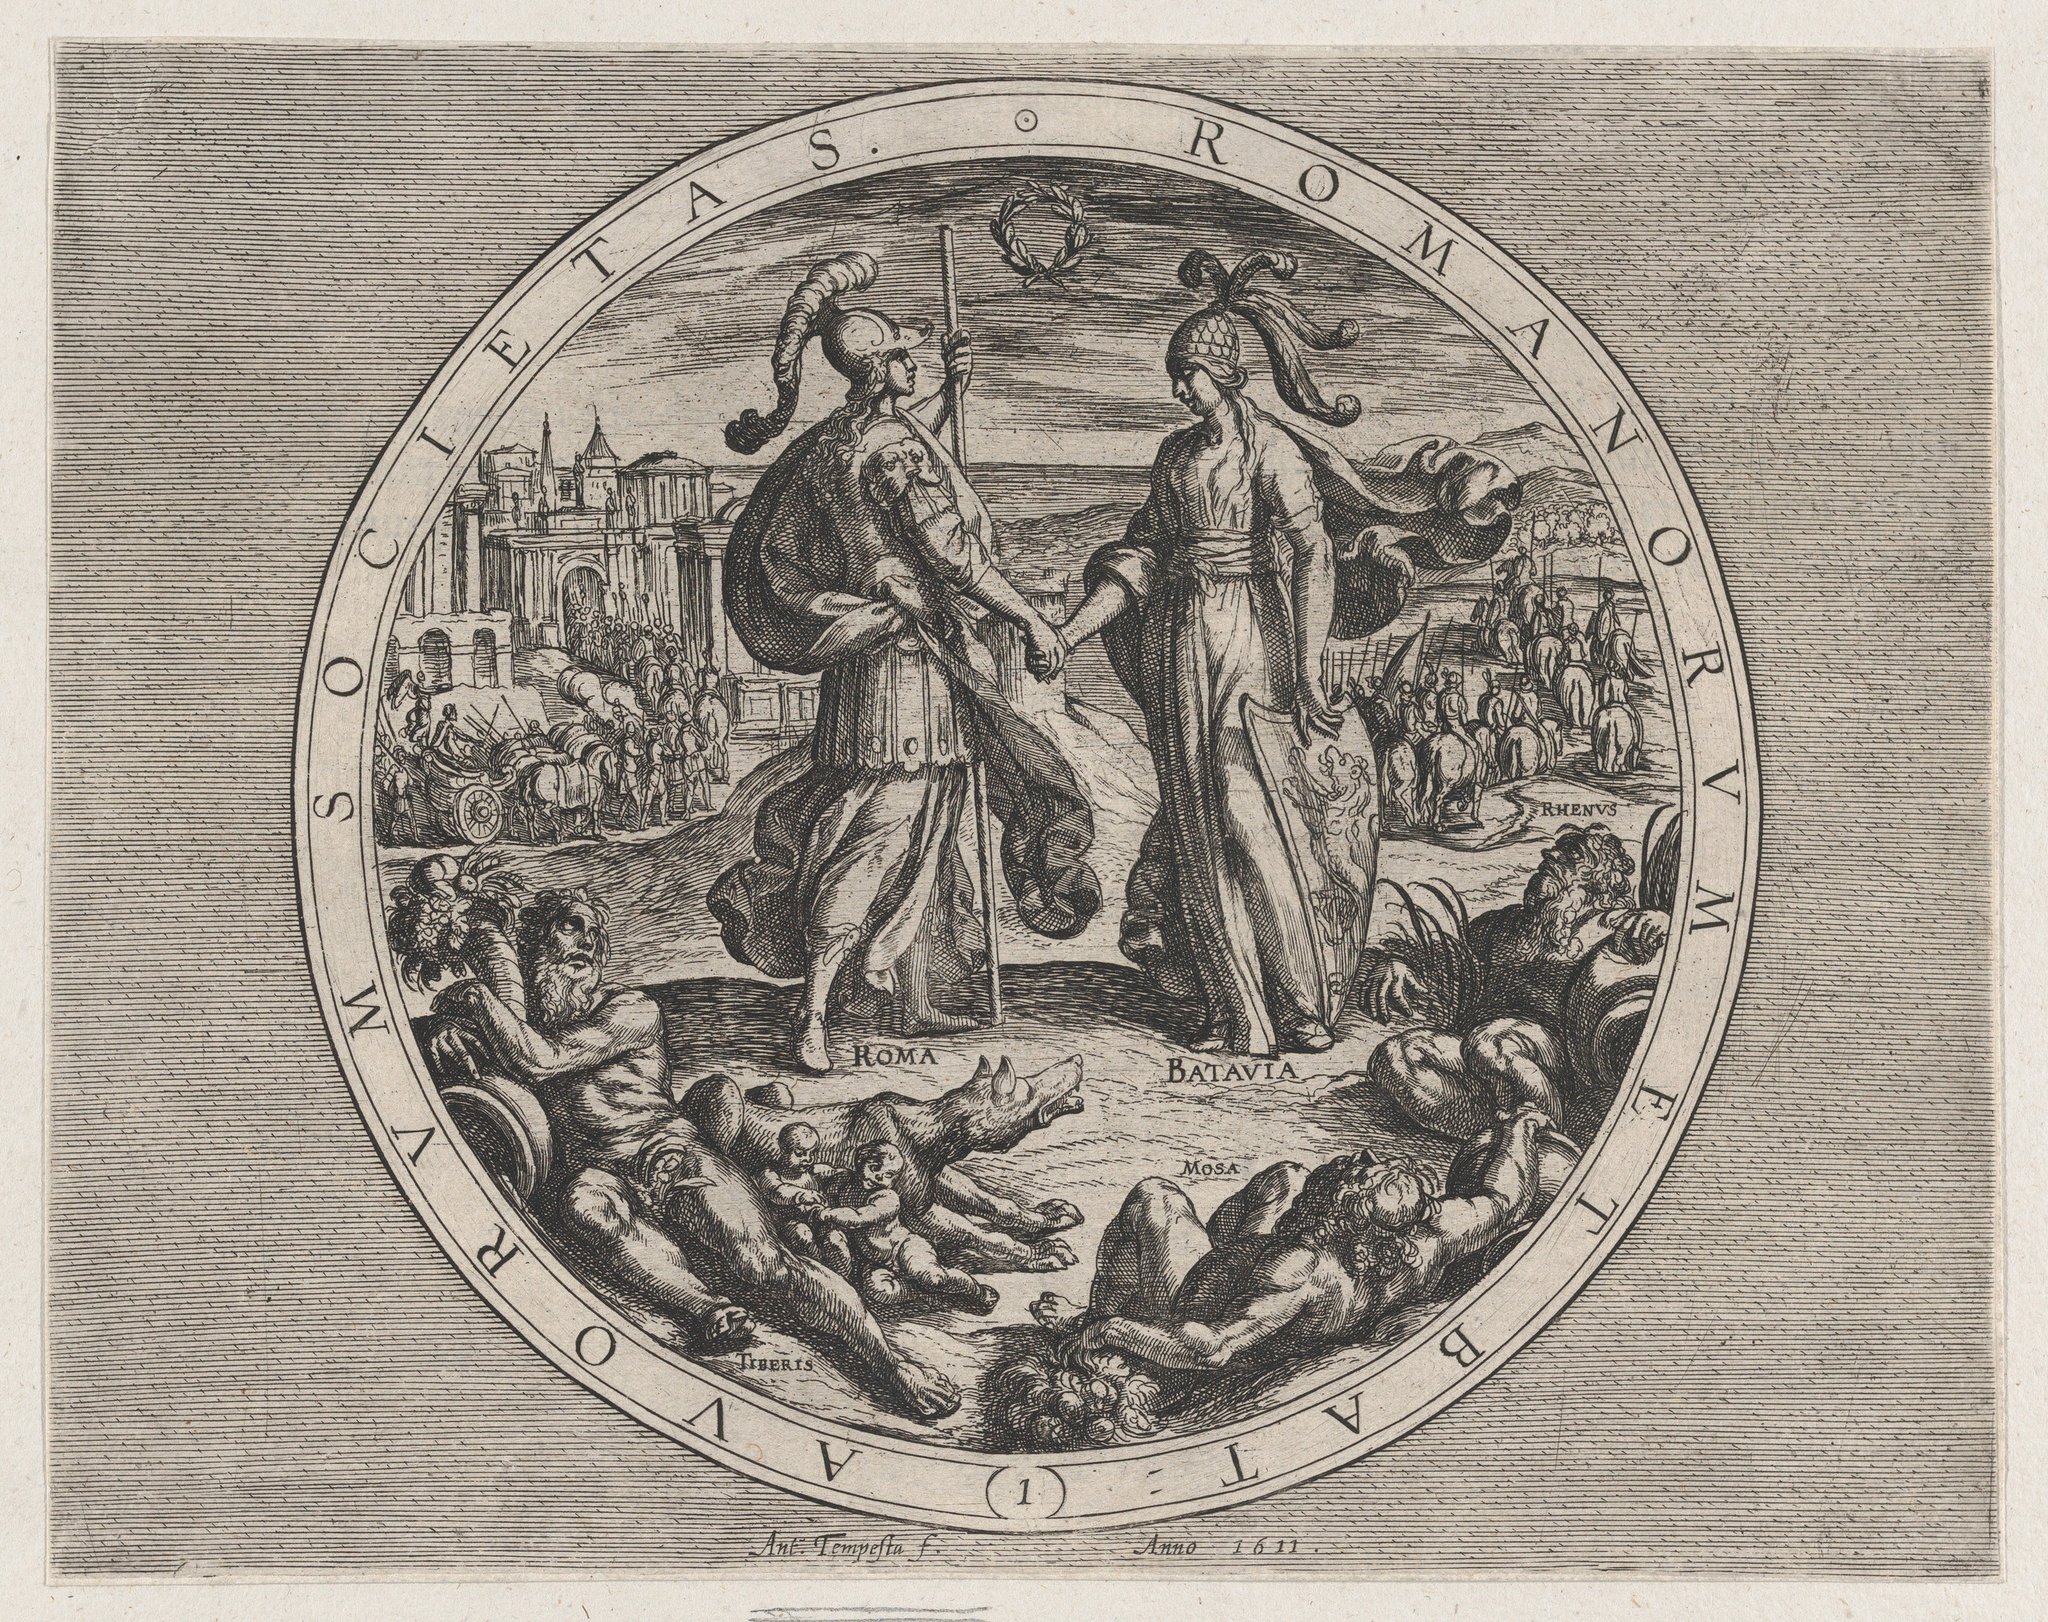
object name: print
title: Plate 1: Roma and Batavia Shaking Hands, from The War of the Romans Against the Batavians (Romanorvm et Batavorvm societas)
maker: antonio tempesta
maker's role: artist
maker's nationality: italian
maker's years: 1555-1630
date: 1611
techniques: etching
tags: animals,wars,infants,men,horses